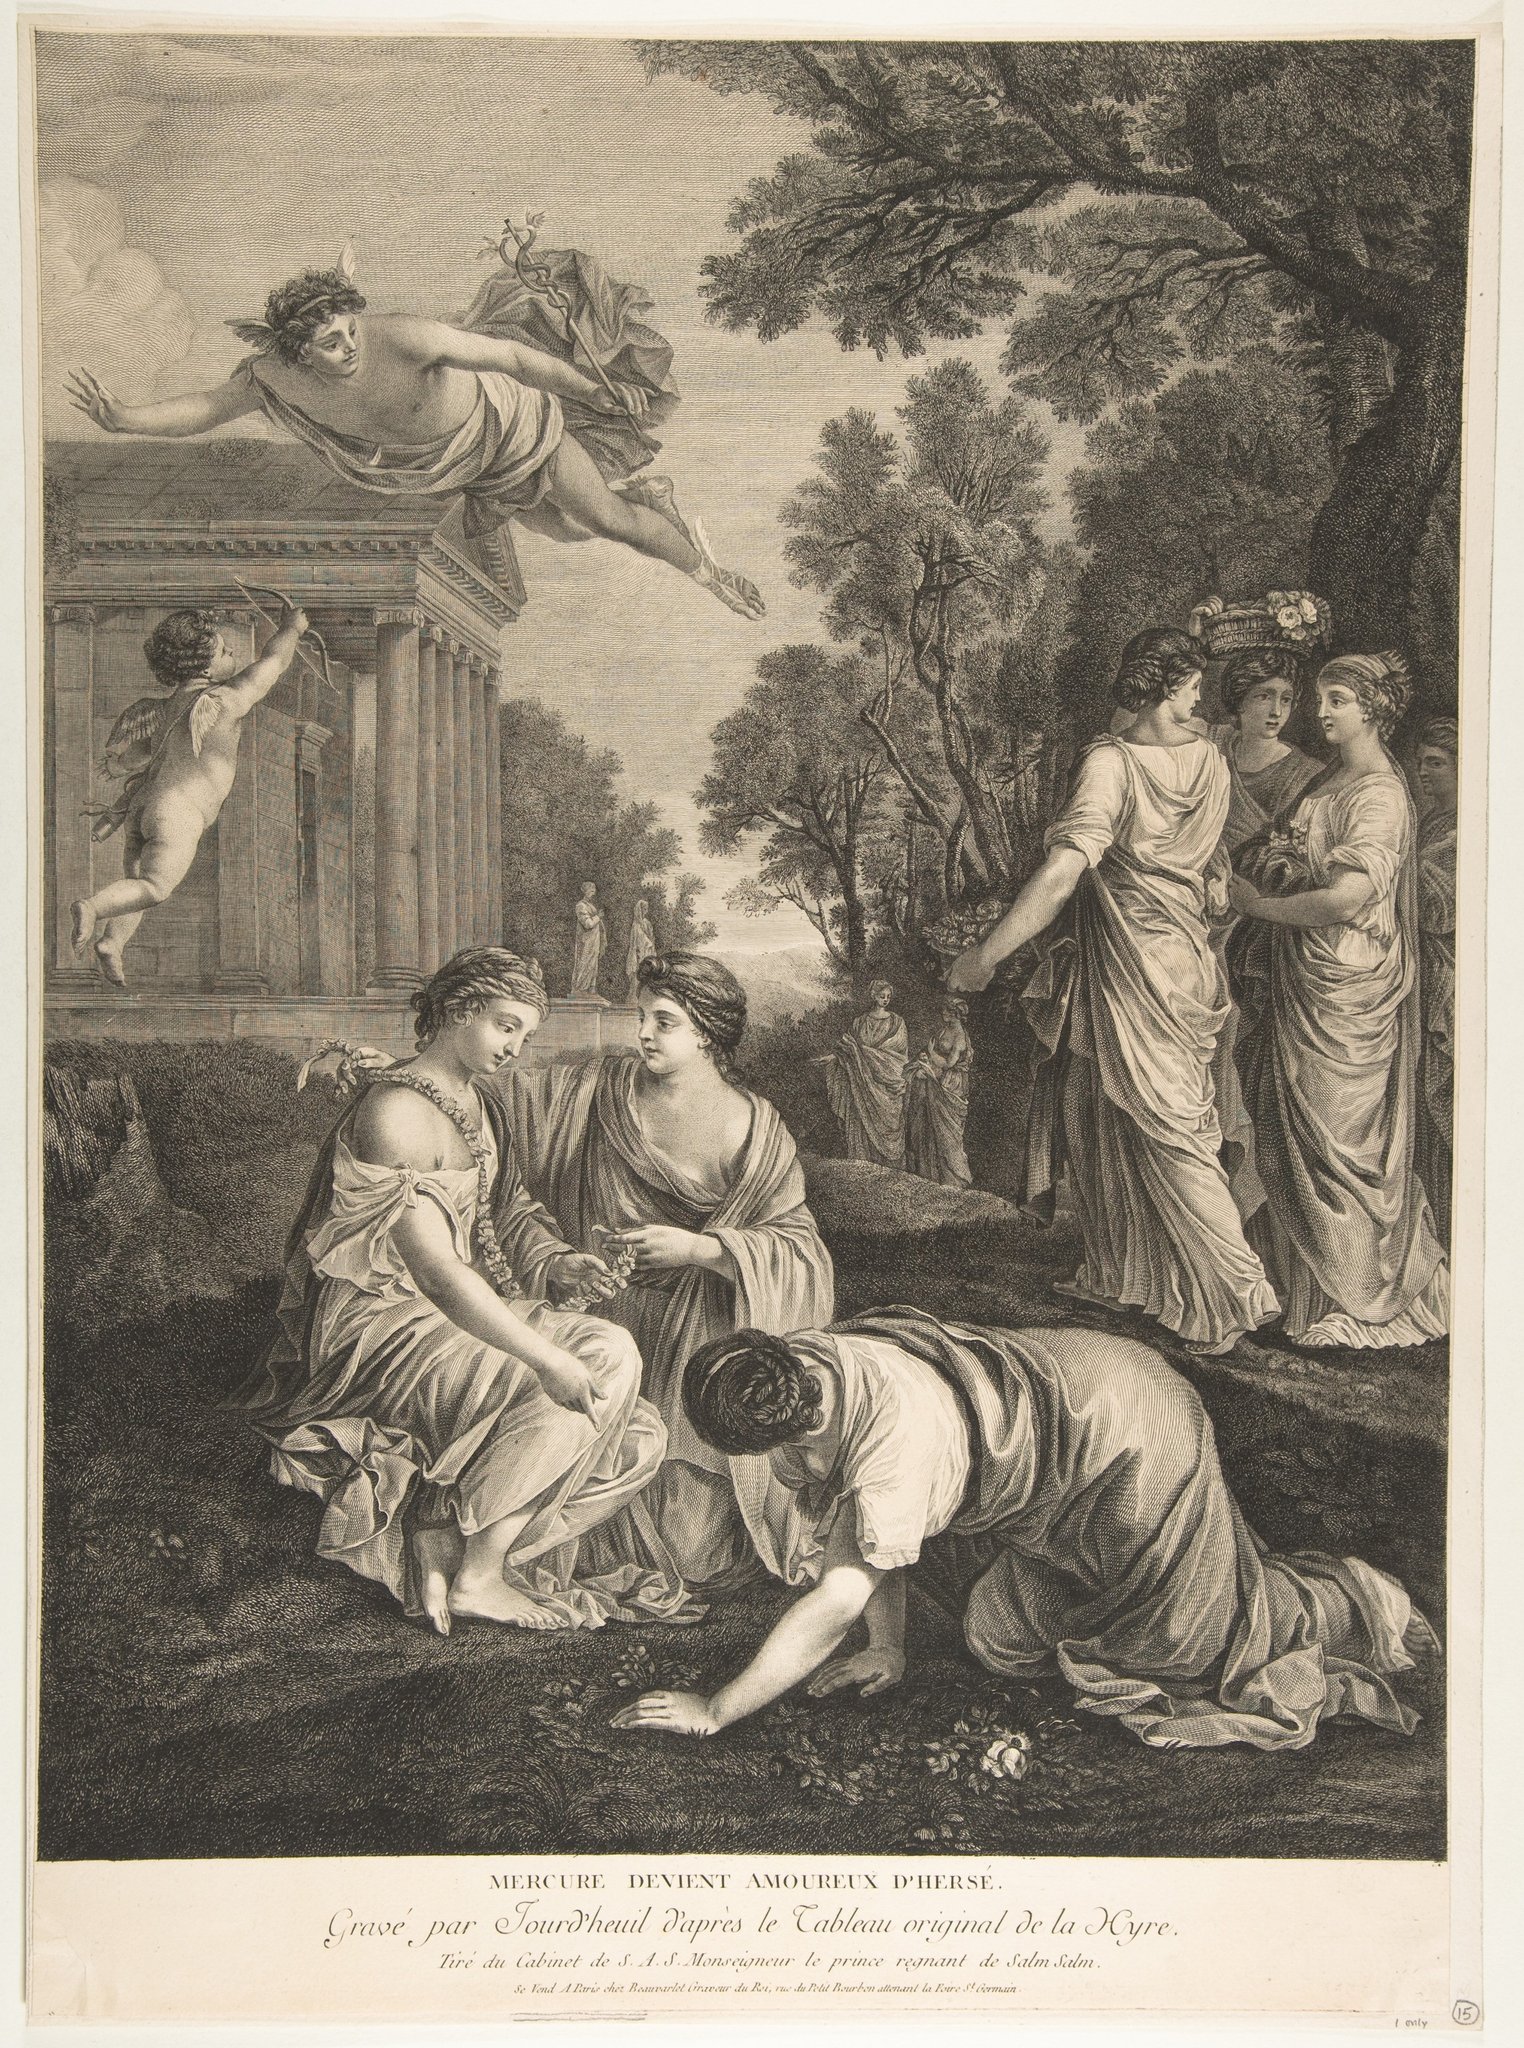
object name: print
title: Mercury and Herse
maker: françois jourd'heuil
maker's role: artist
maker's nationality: french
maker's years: 1759-1781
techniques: engraving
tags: women,mercury